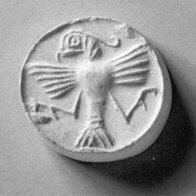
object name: stamp seal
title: Stamp seal and modern impression: birds of prey, one subduing caprids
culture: assyrian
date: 2000-1668 BCE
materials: stone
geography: central anatolia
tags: birds